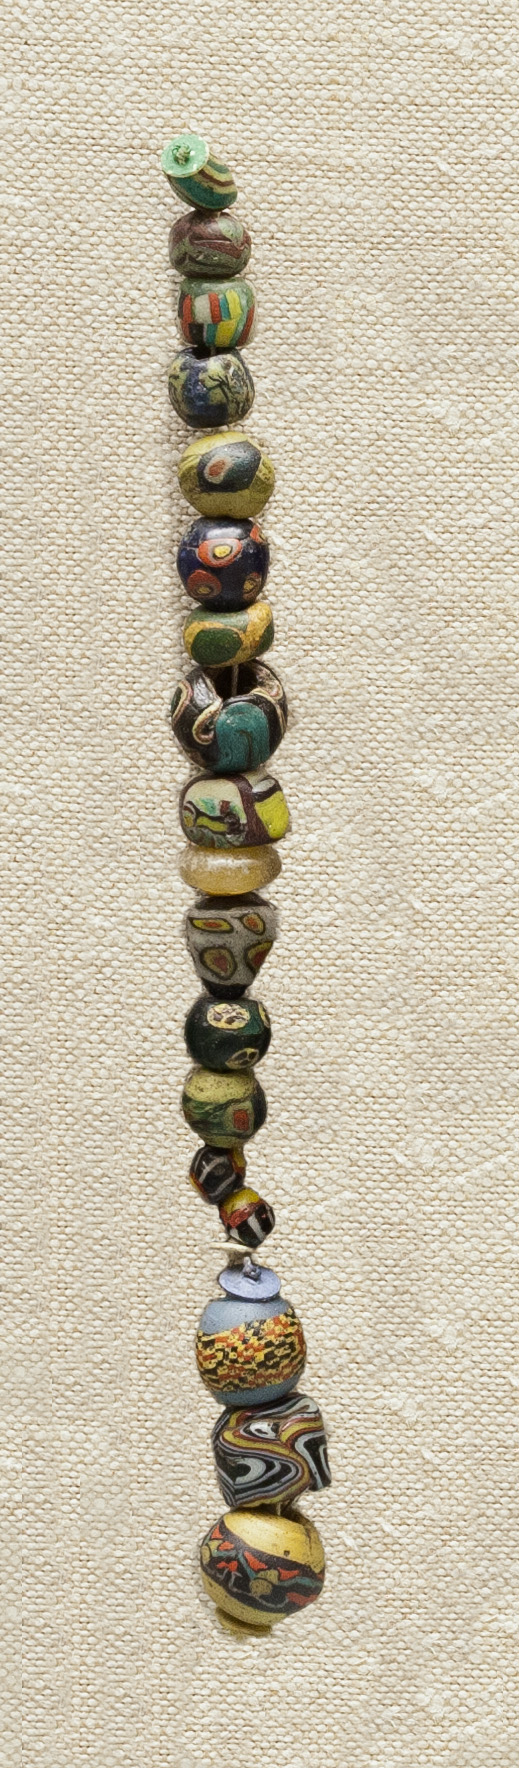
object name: bead, string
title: String of 3 Beads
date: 1-400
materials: glass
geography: egypt